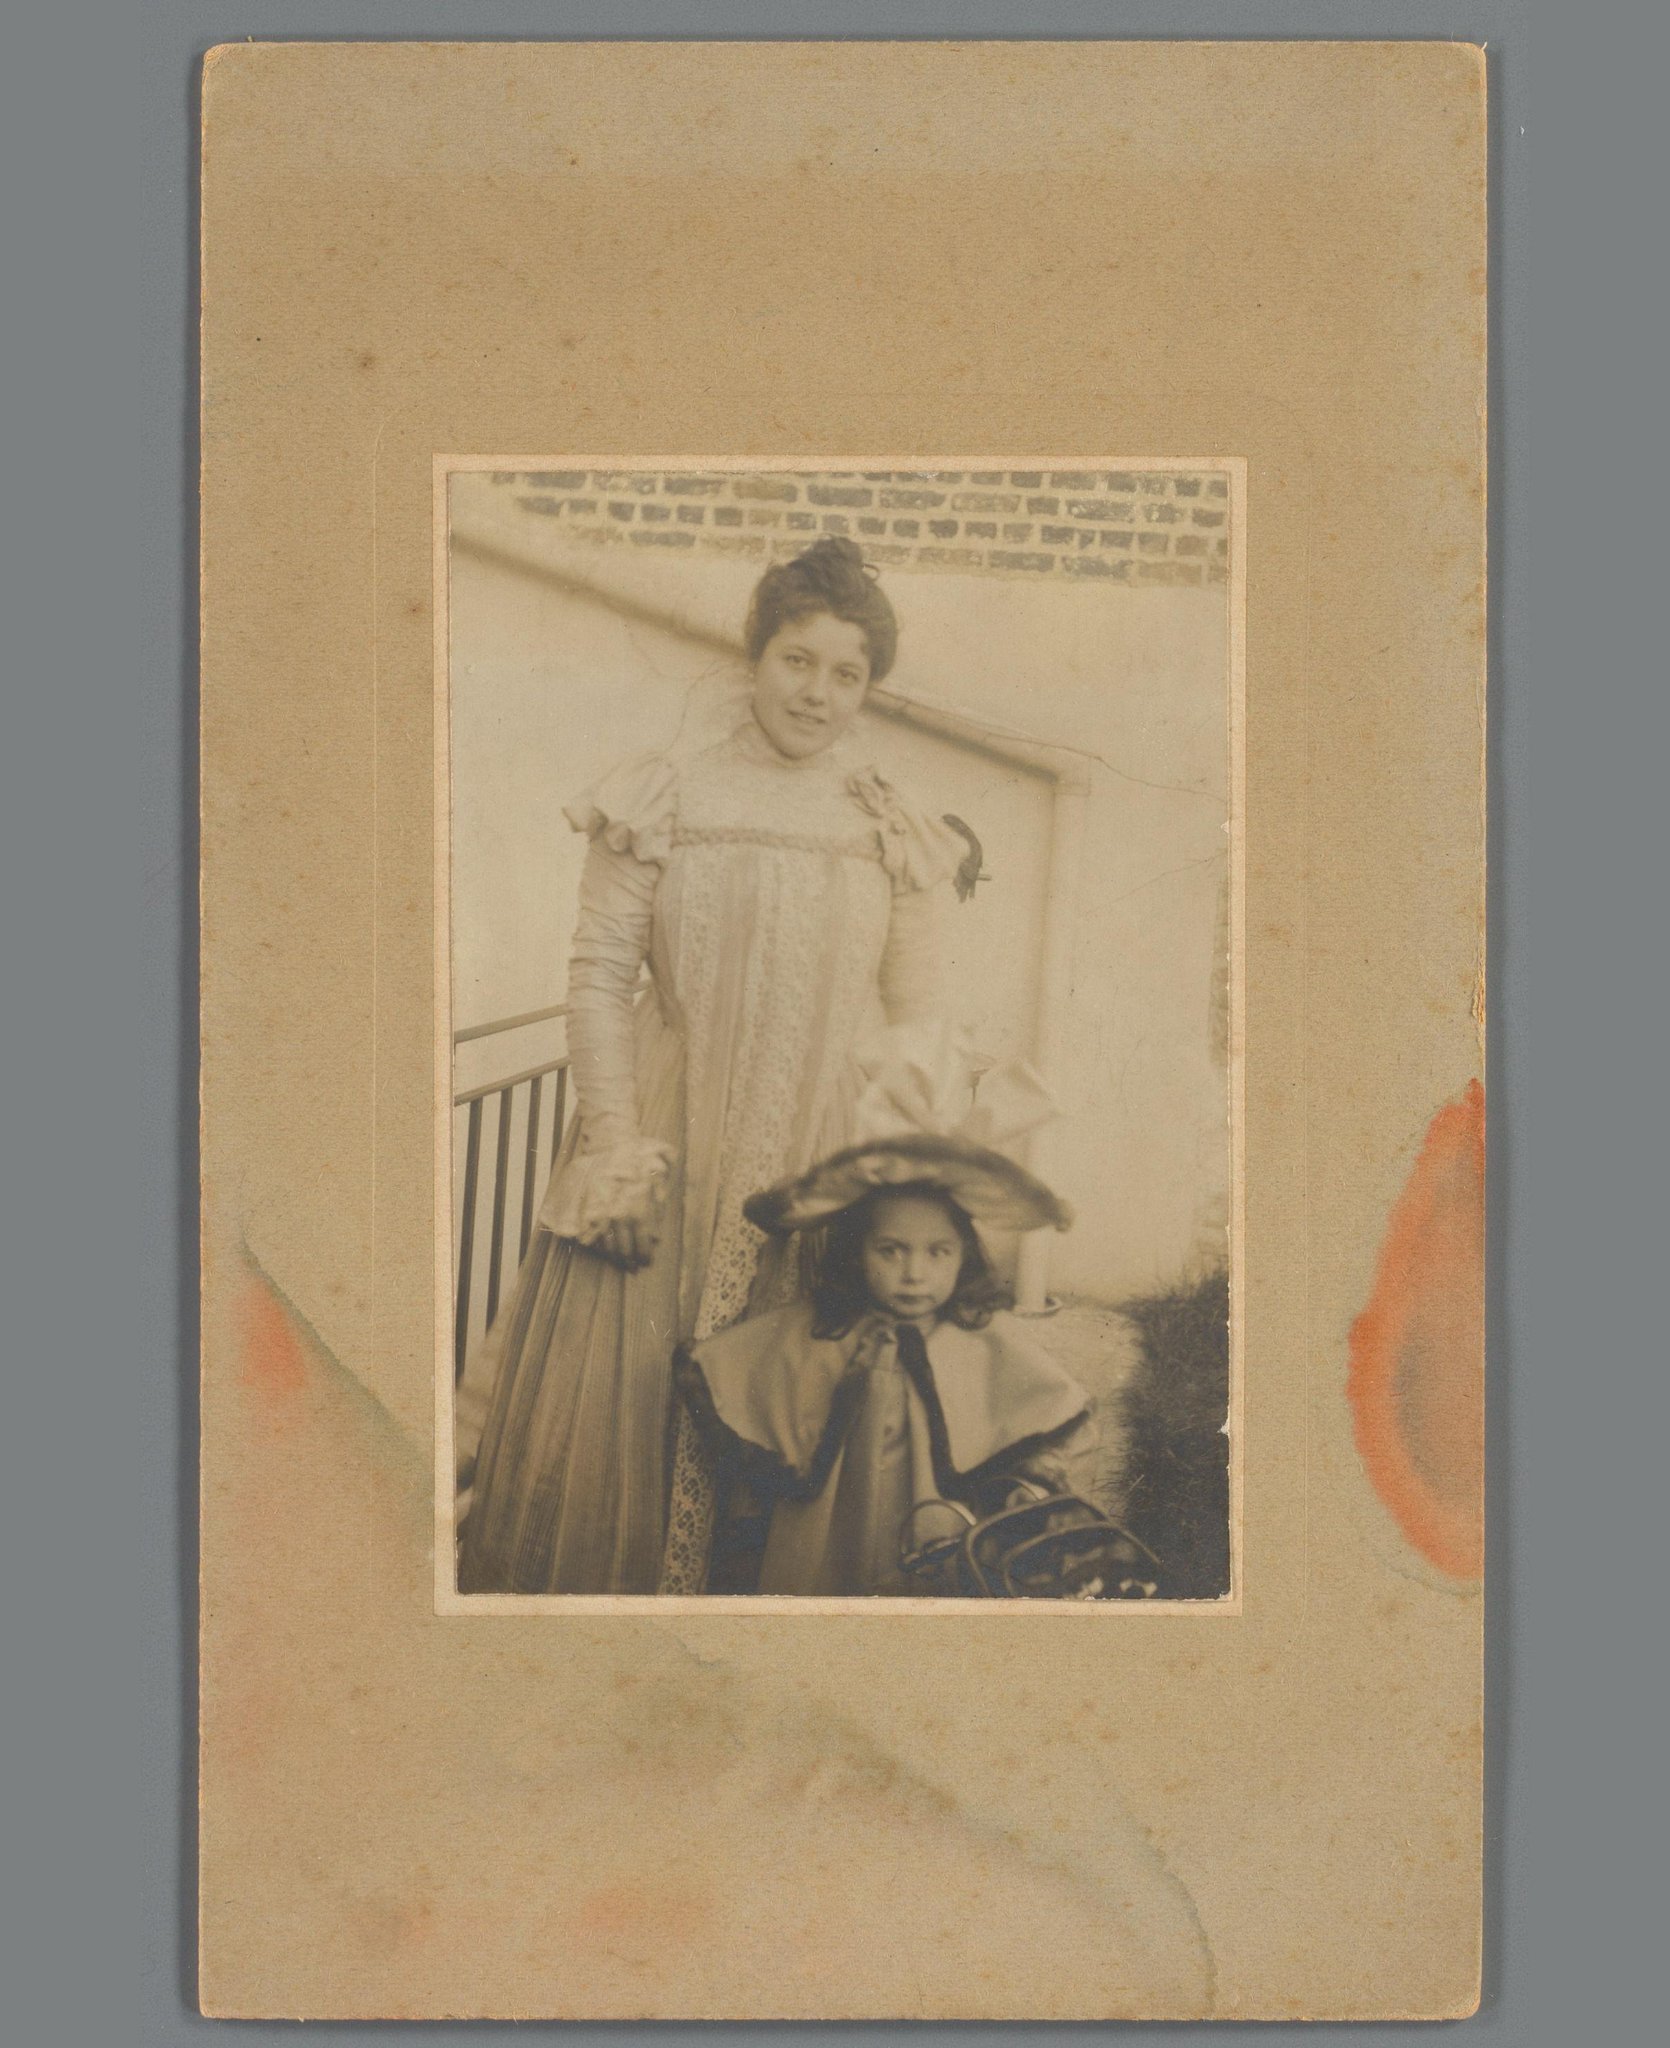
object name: photograph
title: Portret van een onbekende vrouw met een kind uit de familie en de kring van Eugene van Delden en Belle van Delden-Denninghof Stelling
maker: Anonymous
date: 1890-1910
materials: paper, cardboard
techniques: gelatin silver print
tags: historical persons not known by name - bb - woman, mother and baby or young child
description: Portret uit de kring van Eugene van Delden (Hartapoera, 1865 - Den Haag, 1954) en Belle van Delden-Denninghof Stelling (Batavia, 1870 - Den Haag, 1947).